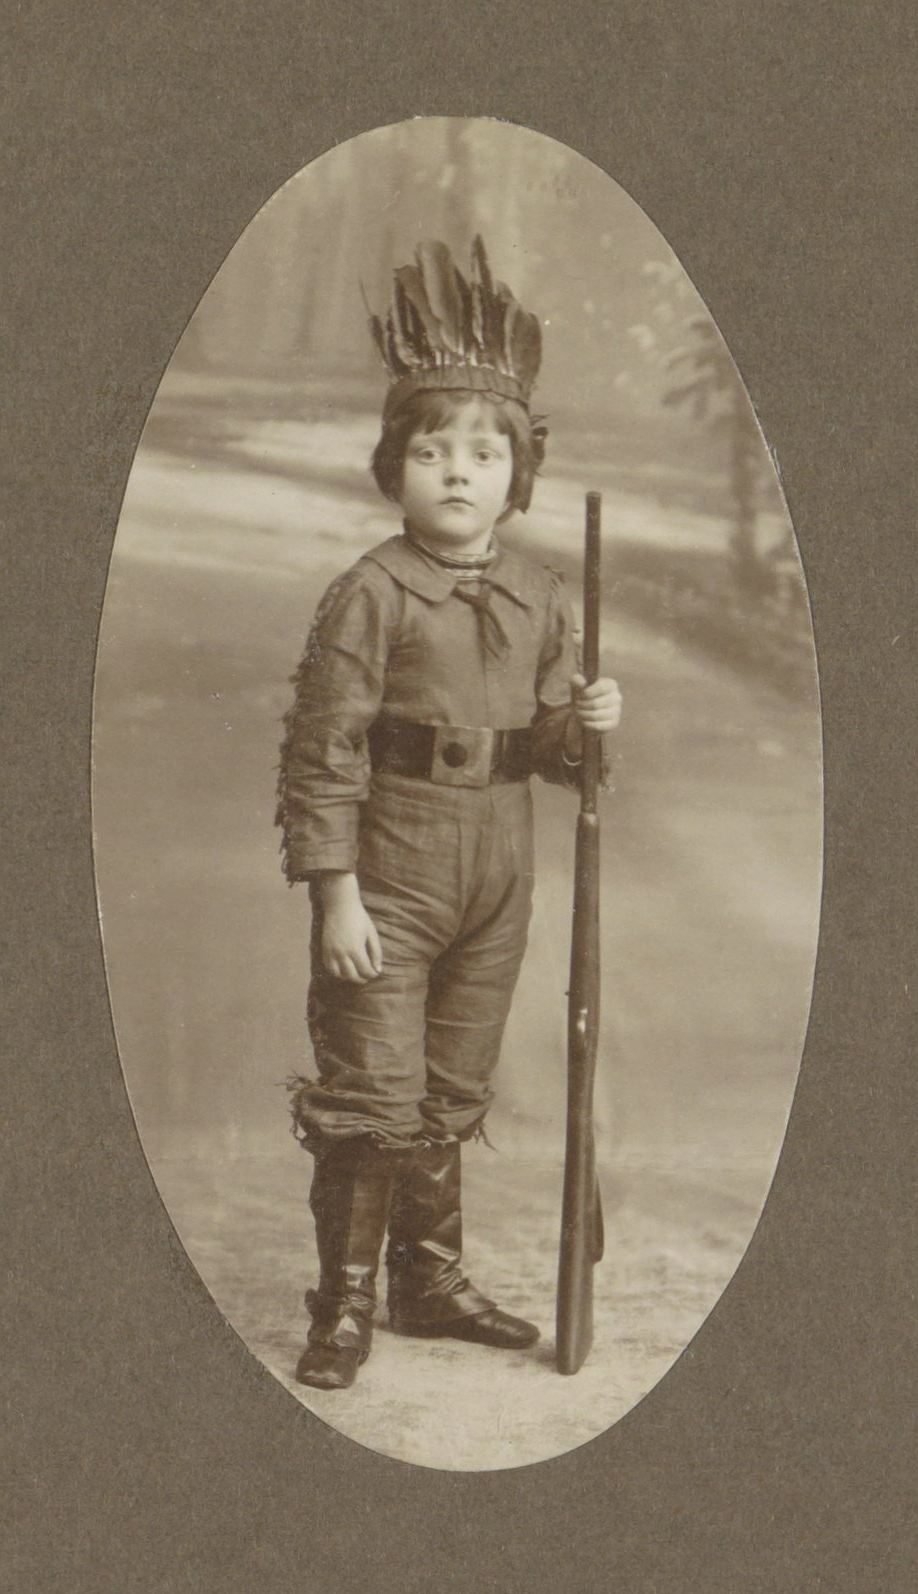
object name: photograph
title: Portret van een kind met verentooi en geweer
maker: cornelis johannes lodewicus vermeulen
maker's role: fotograaf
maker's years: 1861-1936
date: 1900-1920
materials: paper, photographic support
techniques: gelatin silver print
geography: the hague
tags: studio requisites ~ photographer, head-gear, indigenous peoples of north america (+ costume), child, firearms: rifle, the hague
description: Portret van een kind met verentooi en geweer. Onderdeel van Fotoalbum met opnames van het gezin en het huis van fotograaf C.J.L. Vermeulen in Den Haag.